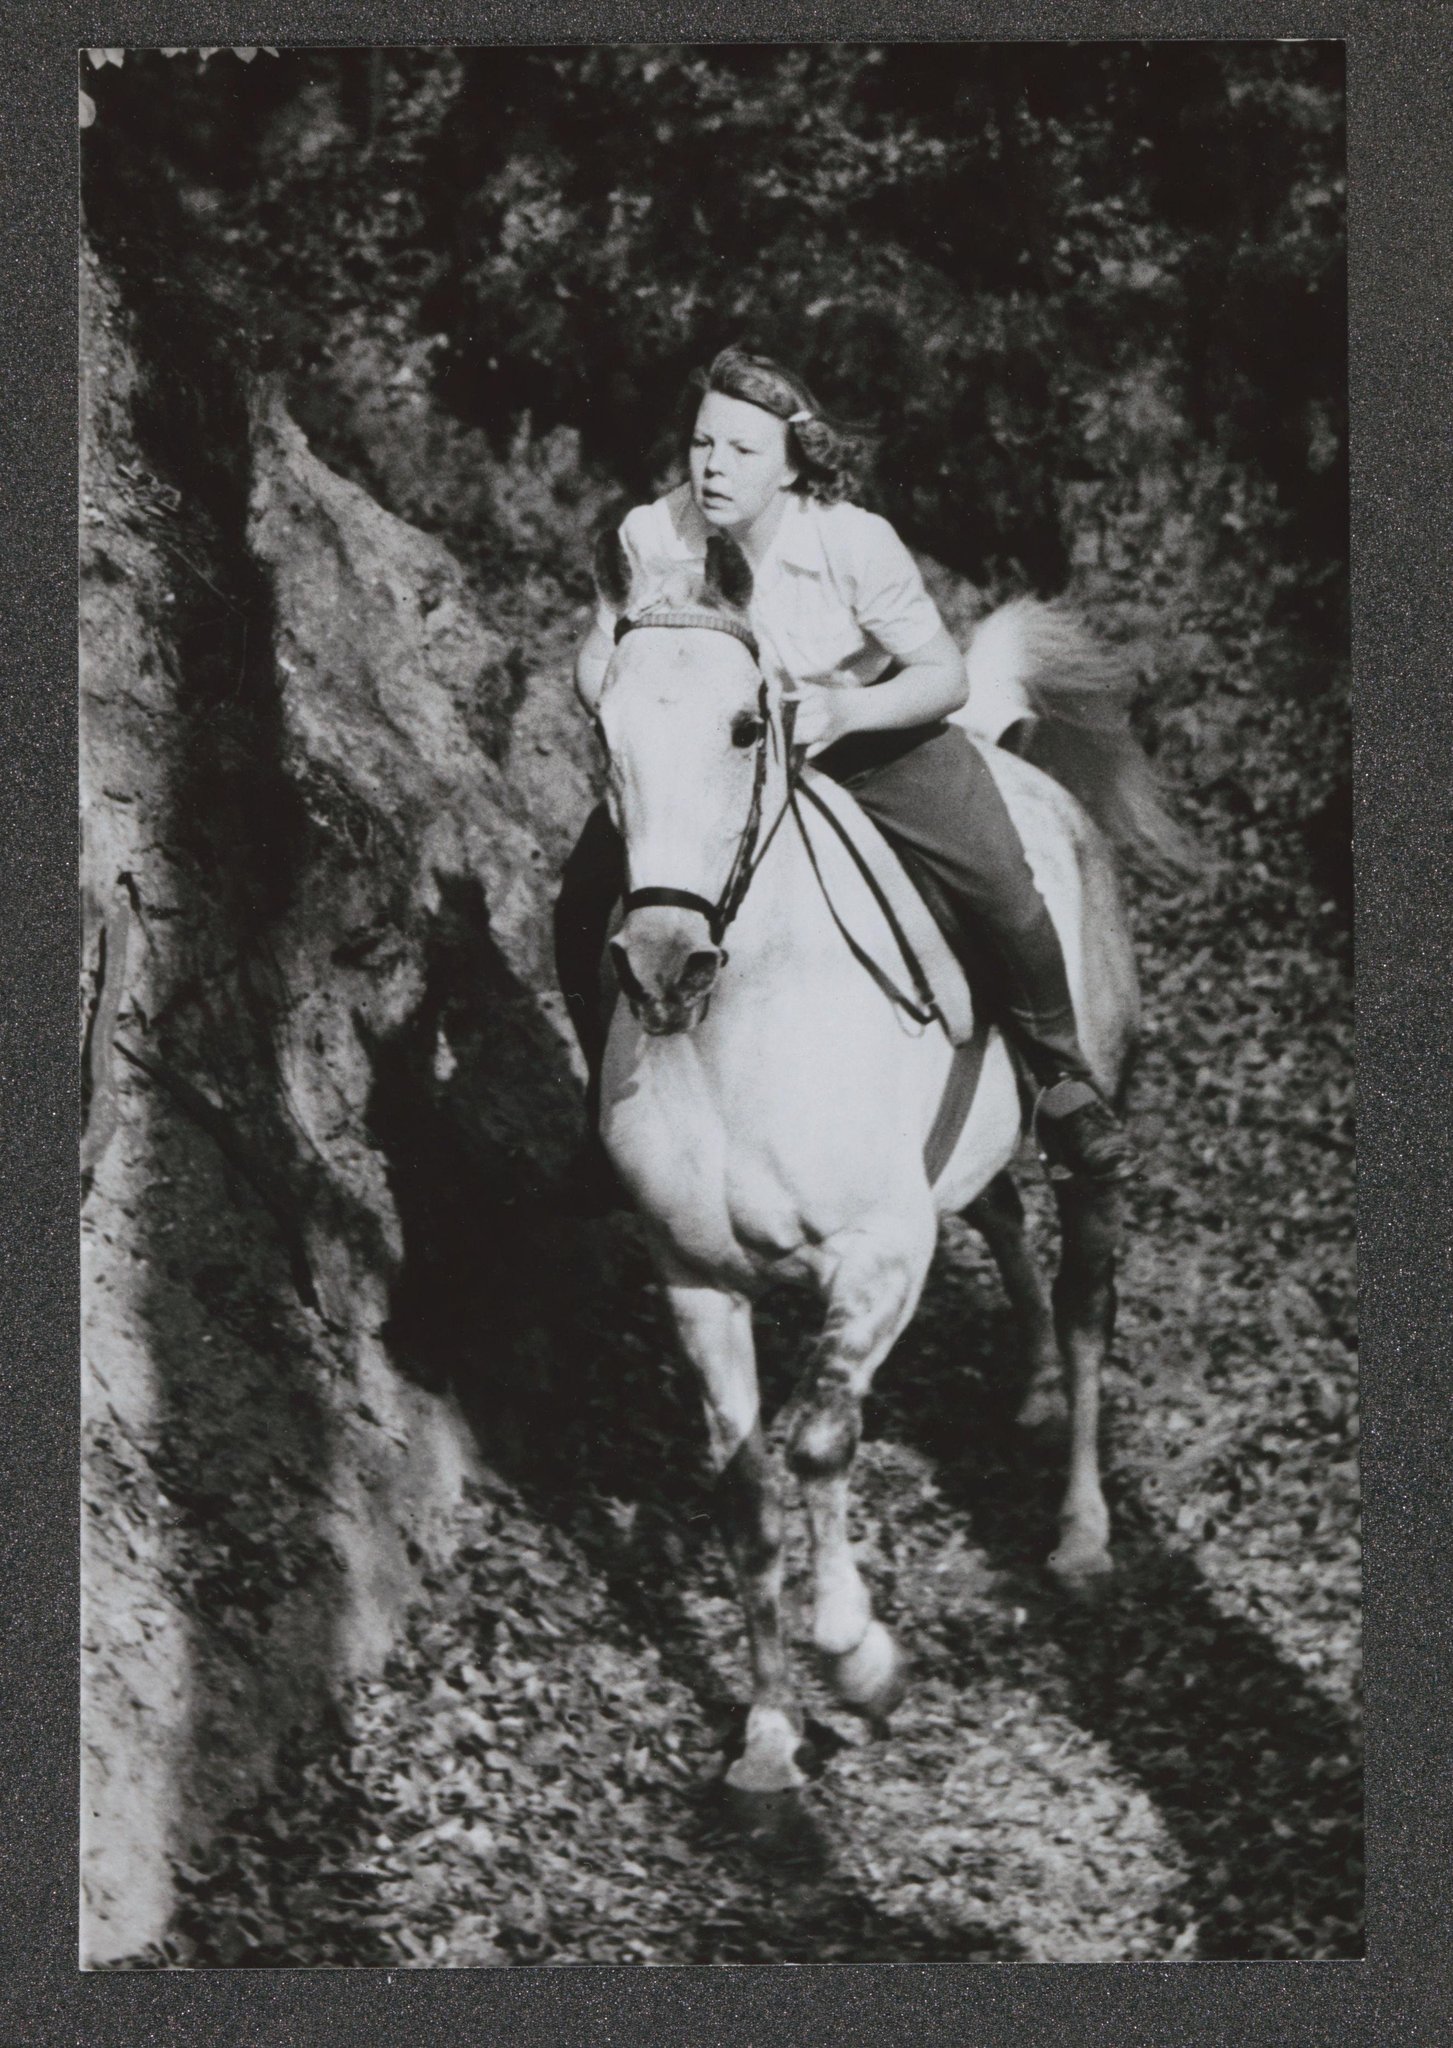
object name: photograph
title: Prinses Beatrix te paard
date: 1959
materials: paper, photographic support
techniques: gelatin silver print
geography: netherlands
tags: beatrix (koningin der nederlanden)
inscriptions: annotation: ‘Saturday 31st, 1959 H.R.H. Crown Princess Beatrix celebrates het 21st birthday and thus attains Her majority. Picture from the files: in April, 1952, during a cross country. PHOTO ANEFO 28-1-1959’